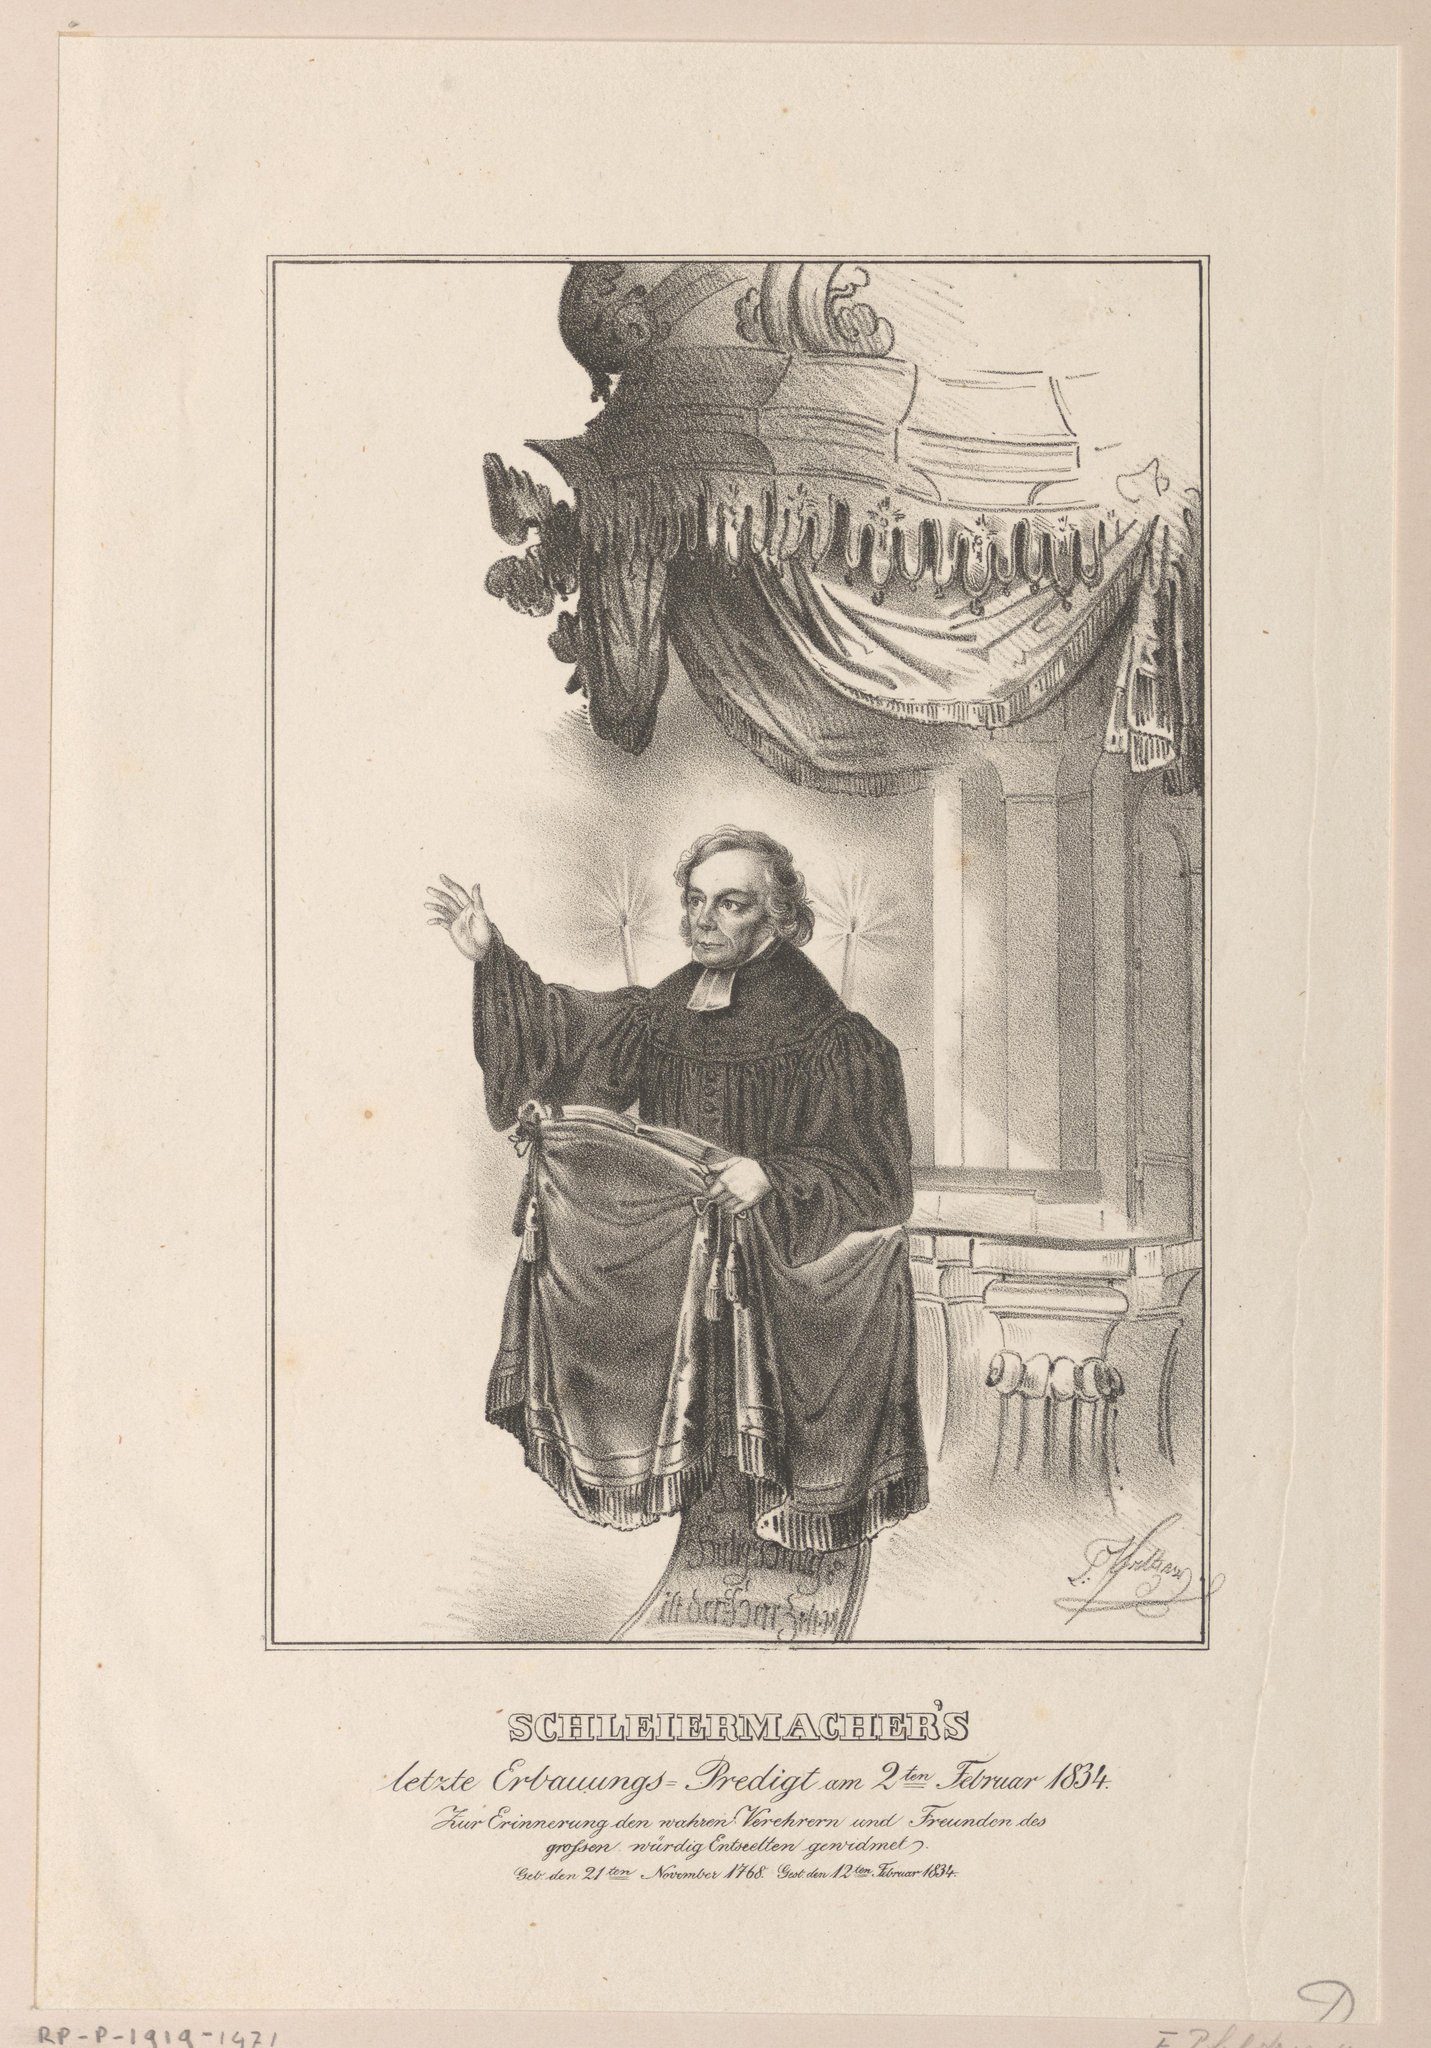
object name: print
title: Portret van Friedrich Ernst Daniel Schleiermacher tijdens zijn laatste preek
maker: Anonymous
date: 1834-1849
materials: paper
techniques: lithograph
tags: berlin, theologian, historical persons, preaching (in general)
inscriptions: collector's mark: Lugt 2228, monogram:, inscription: ‘D’